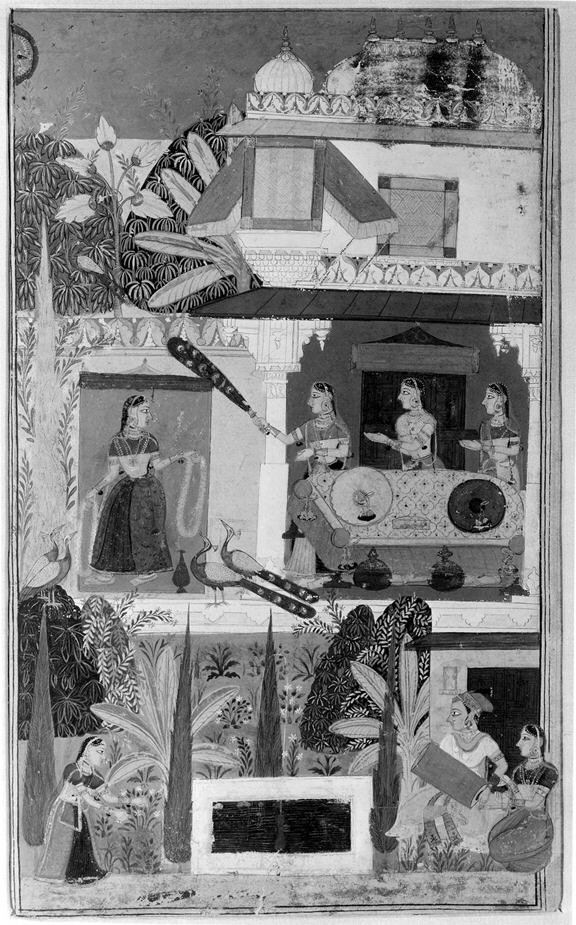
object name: folio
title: Kakubha Ragini: Page from a Dispersed Ragamala Series (Garland of Musical Modes)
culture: mewar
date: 1680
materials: ink, paper, watercolor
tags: men,women,peacocks